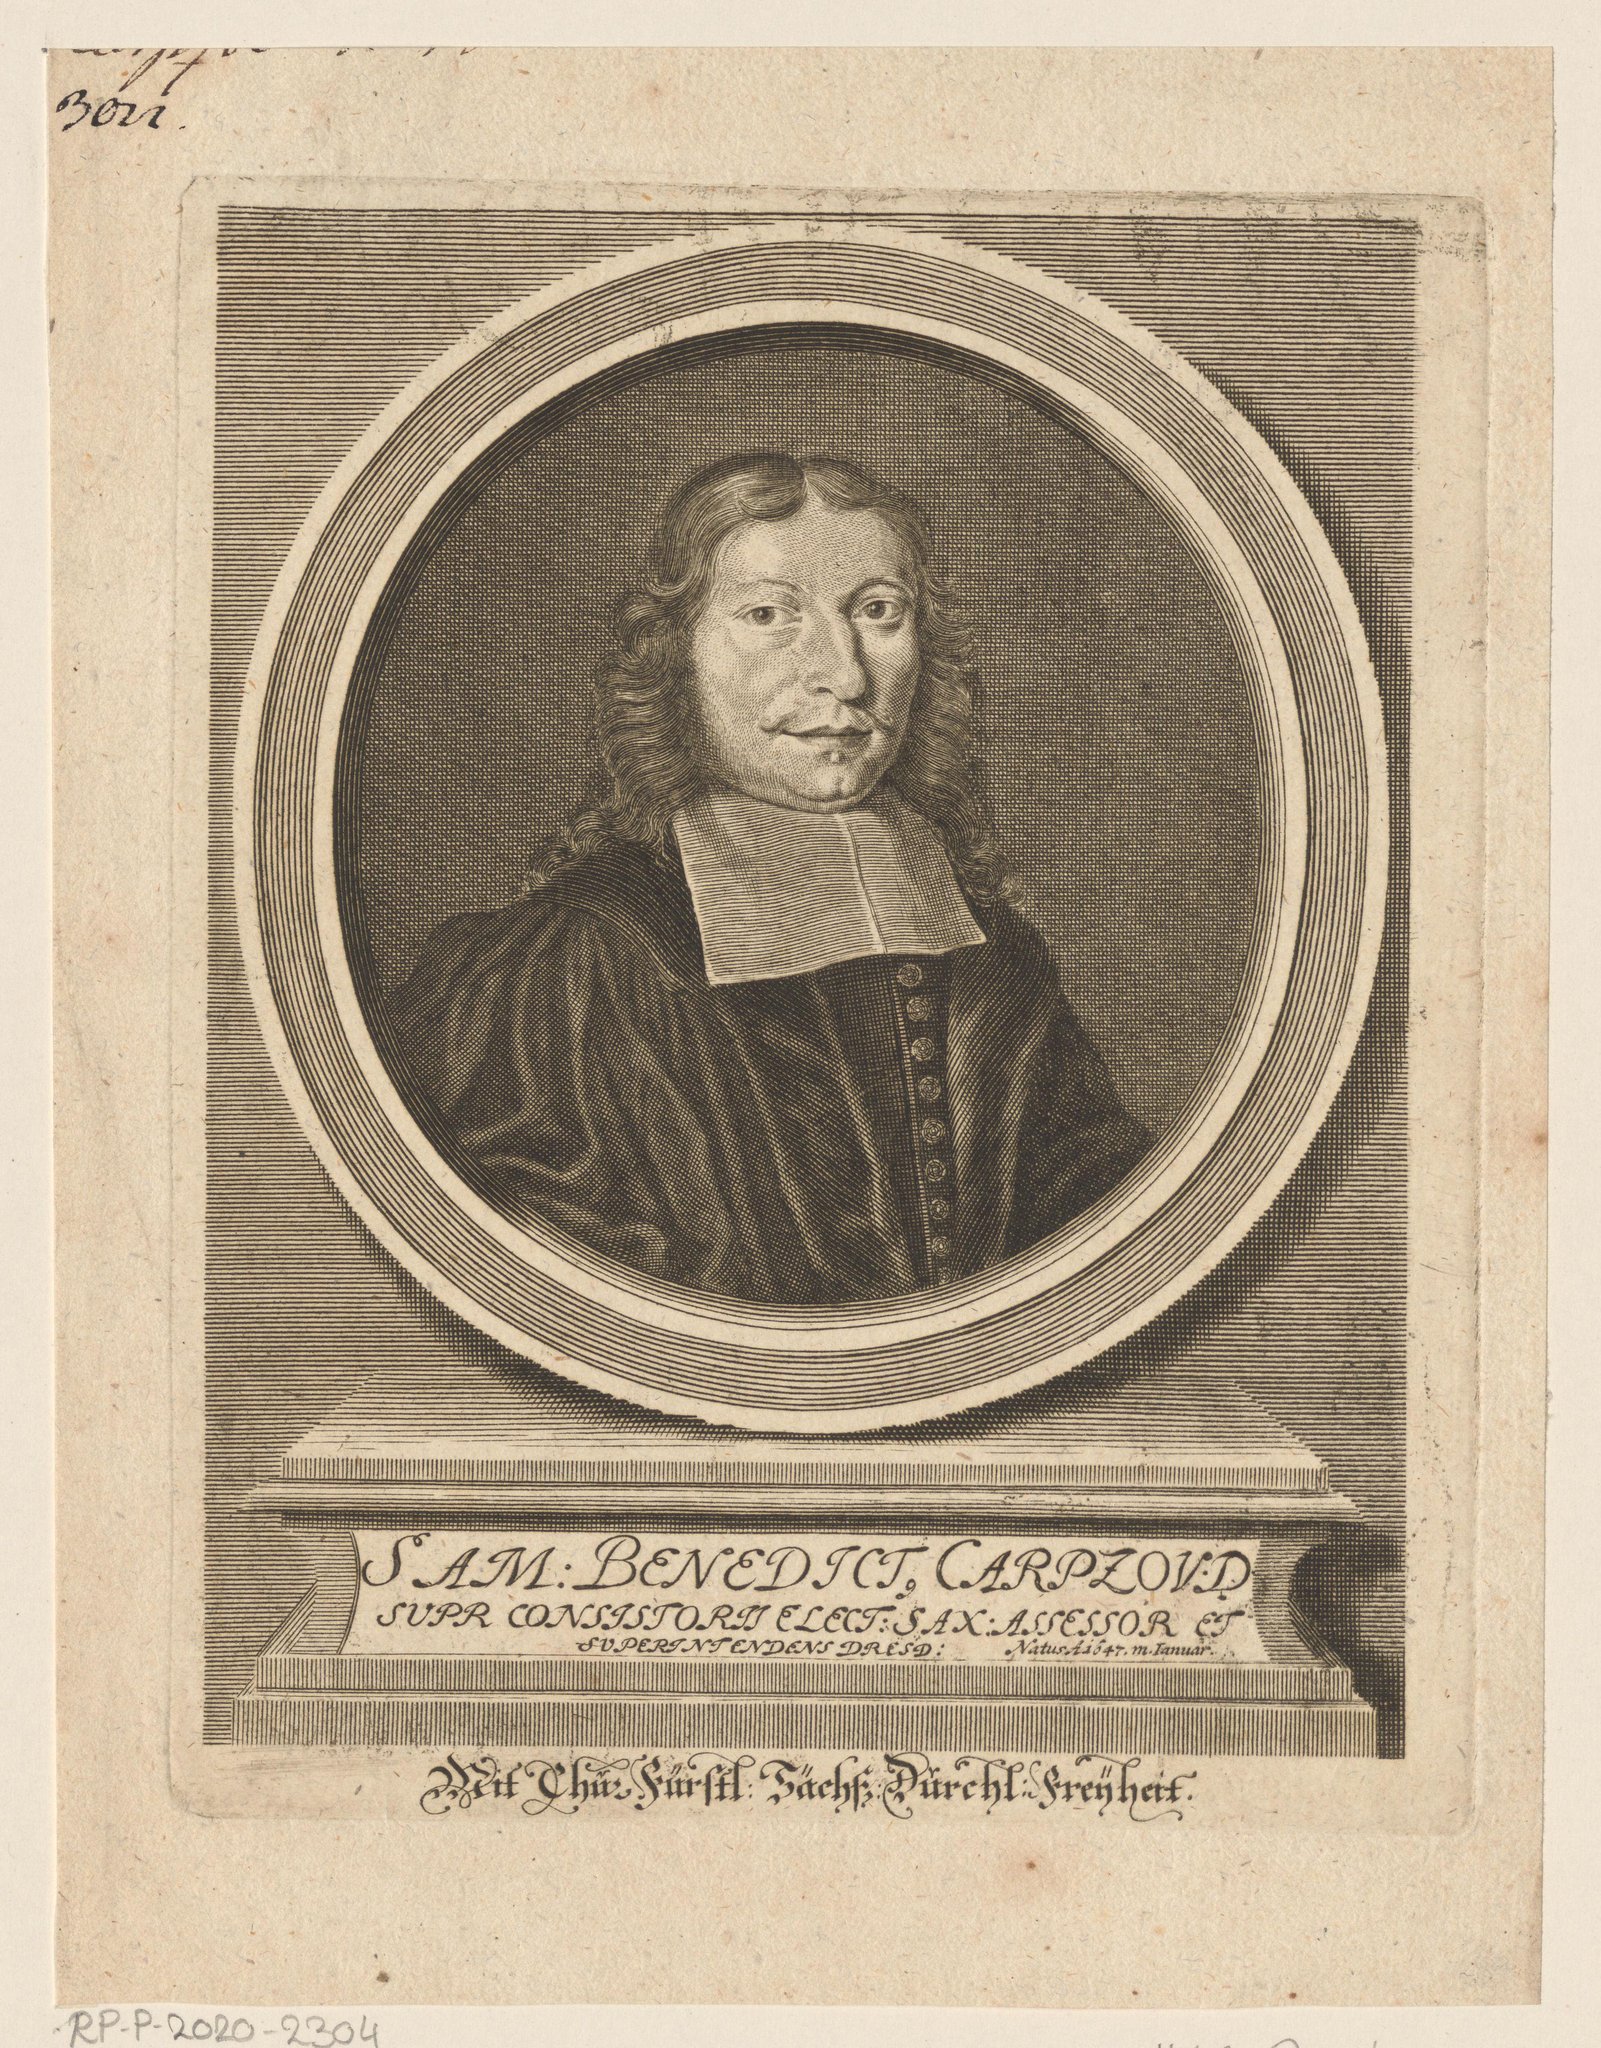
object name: print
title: Portret van Samuel Benedikt Carpzov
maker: Anonymous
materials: paper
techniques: engraving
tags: samuel benedikt carpzov, historical persons